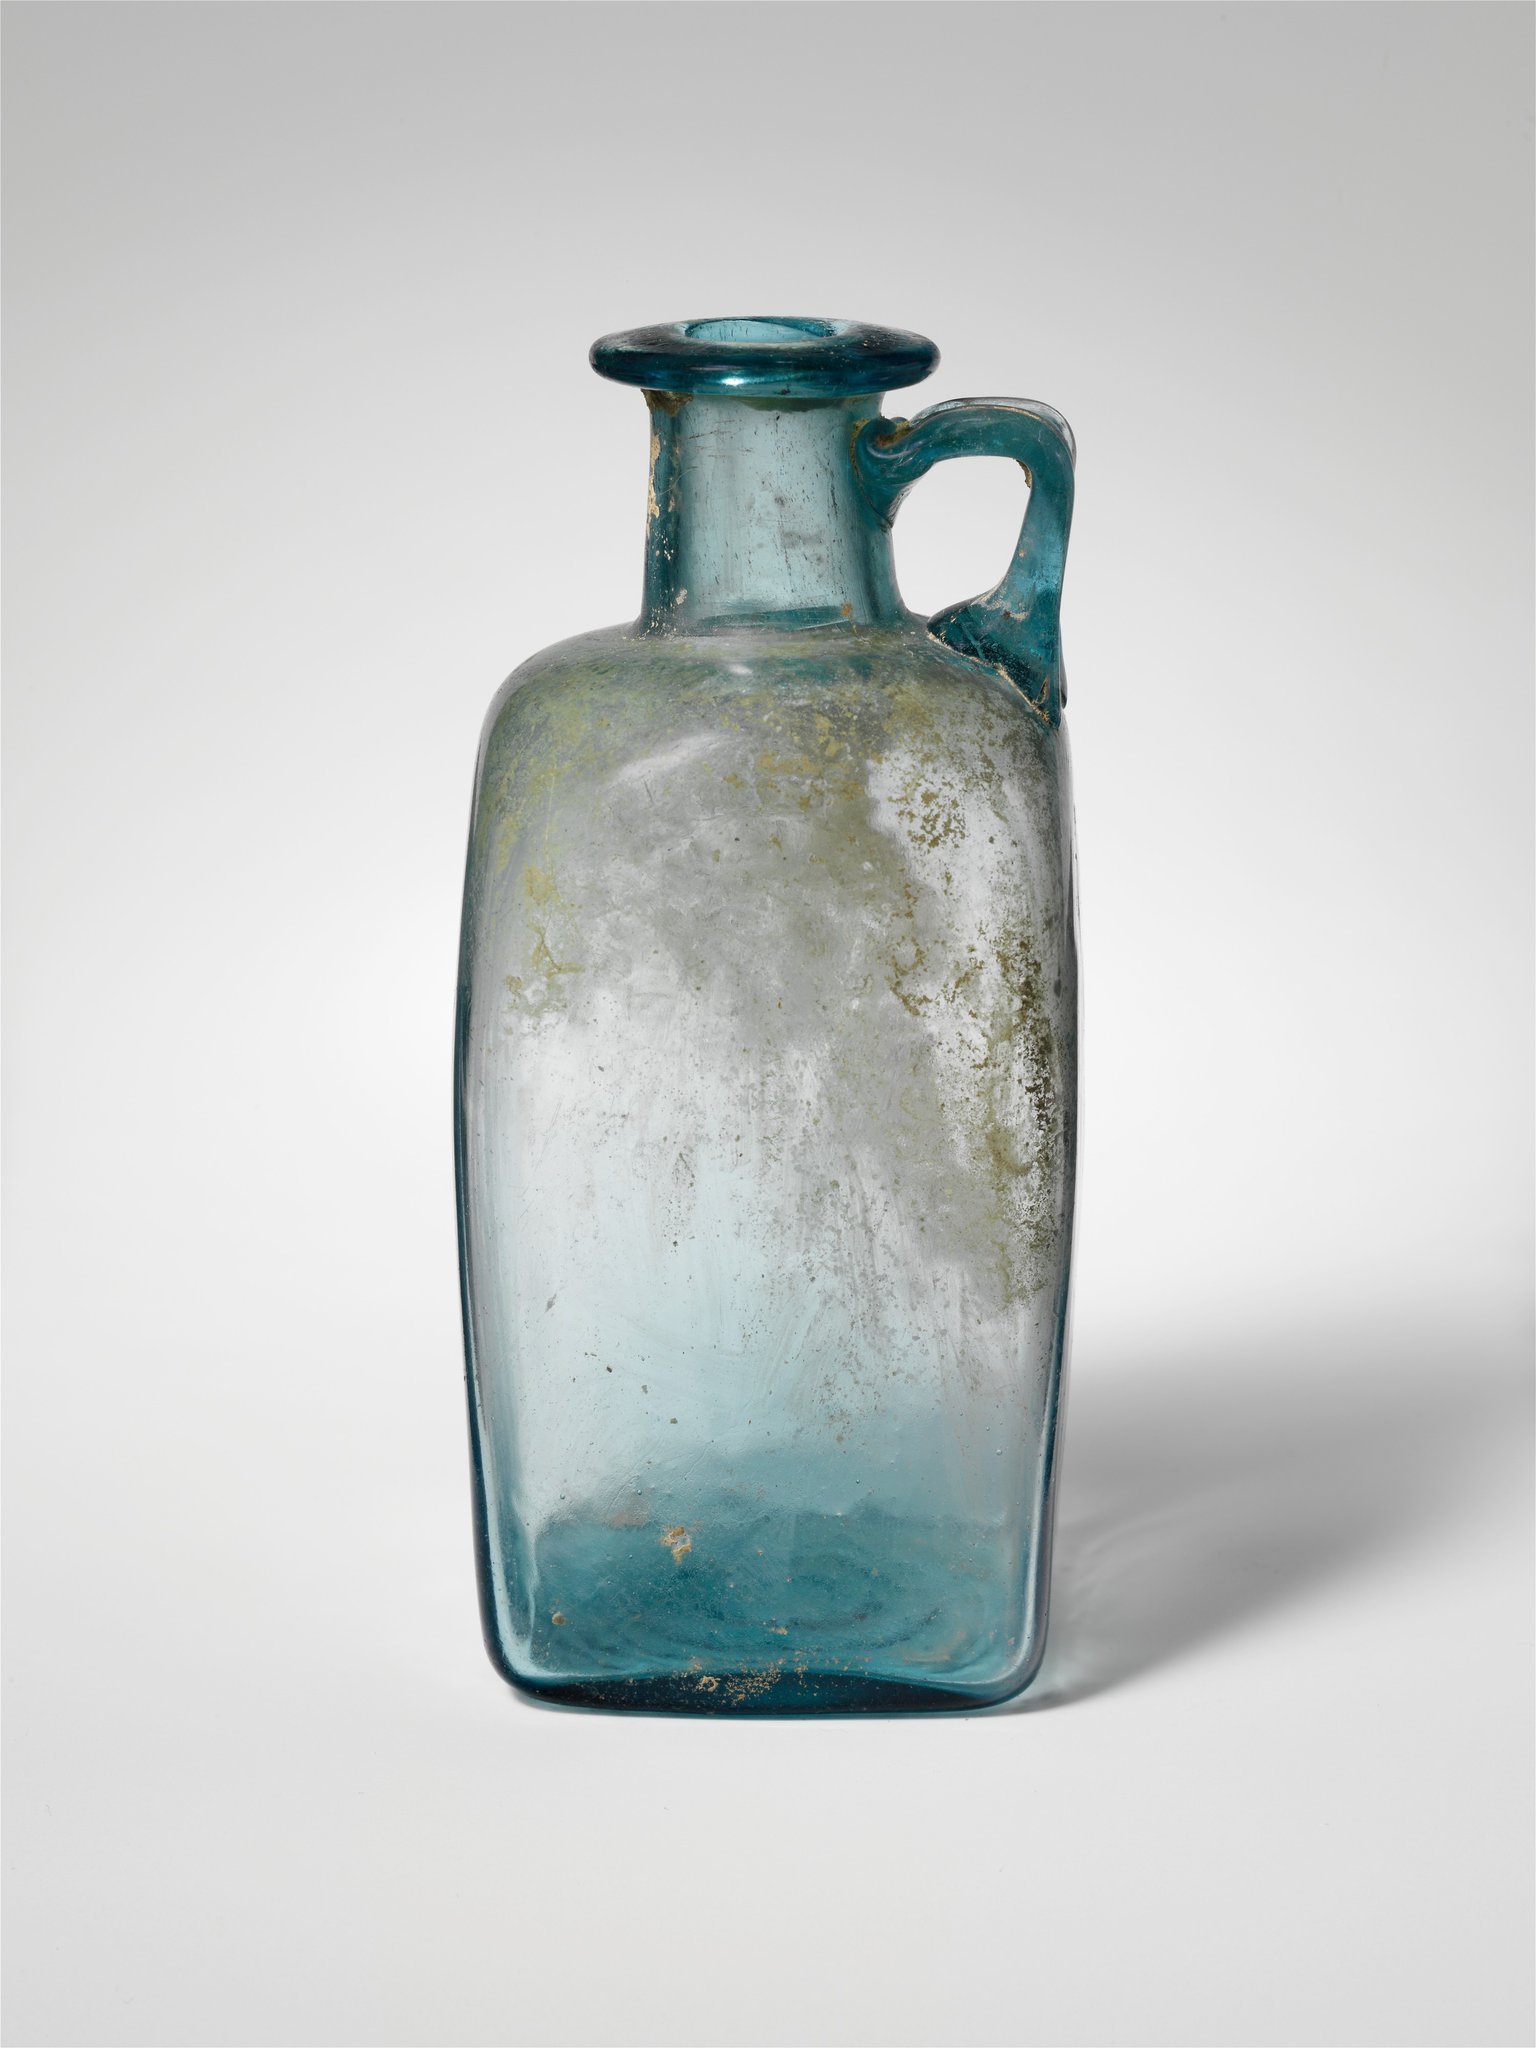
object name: bottle, square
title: Glass square bottle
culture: roman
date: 1-200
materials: glass